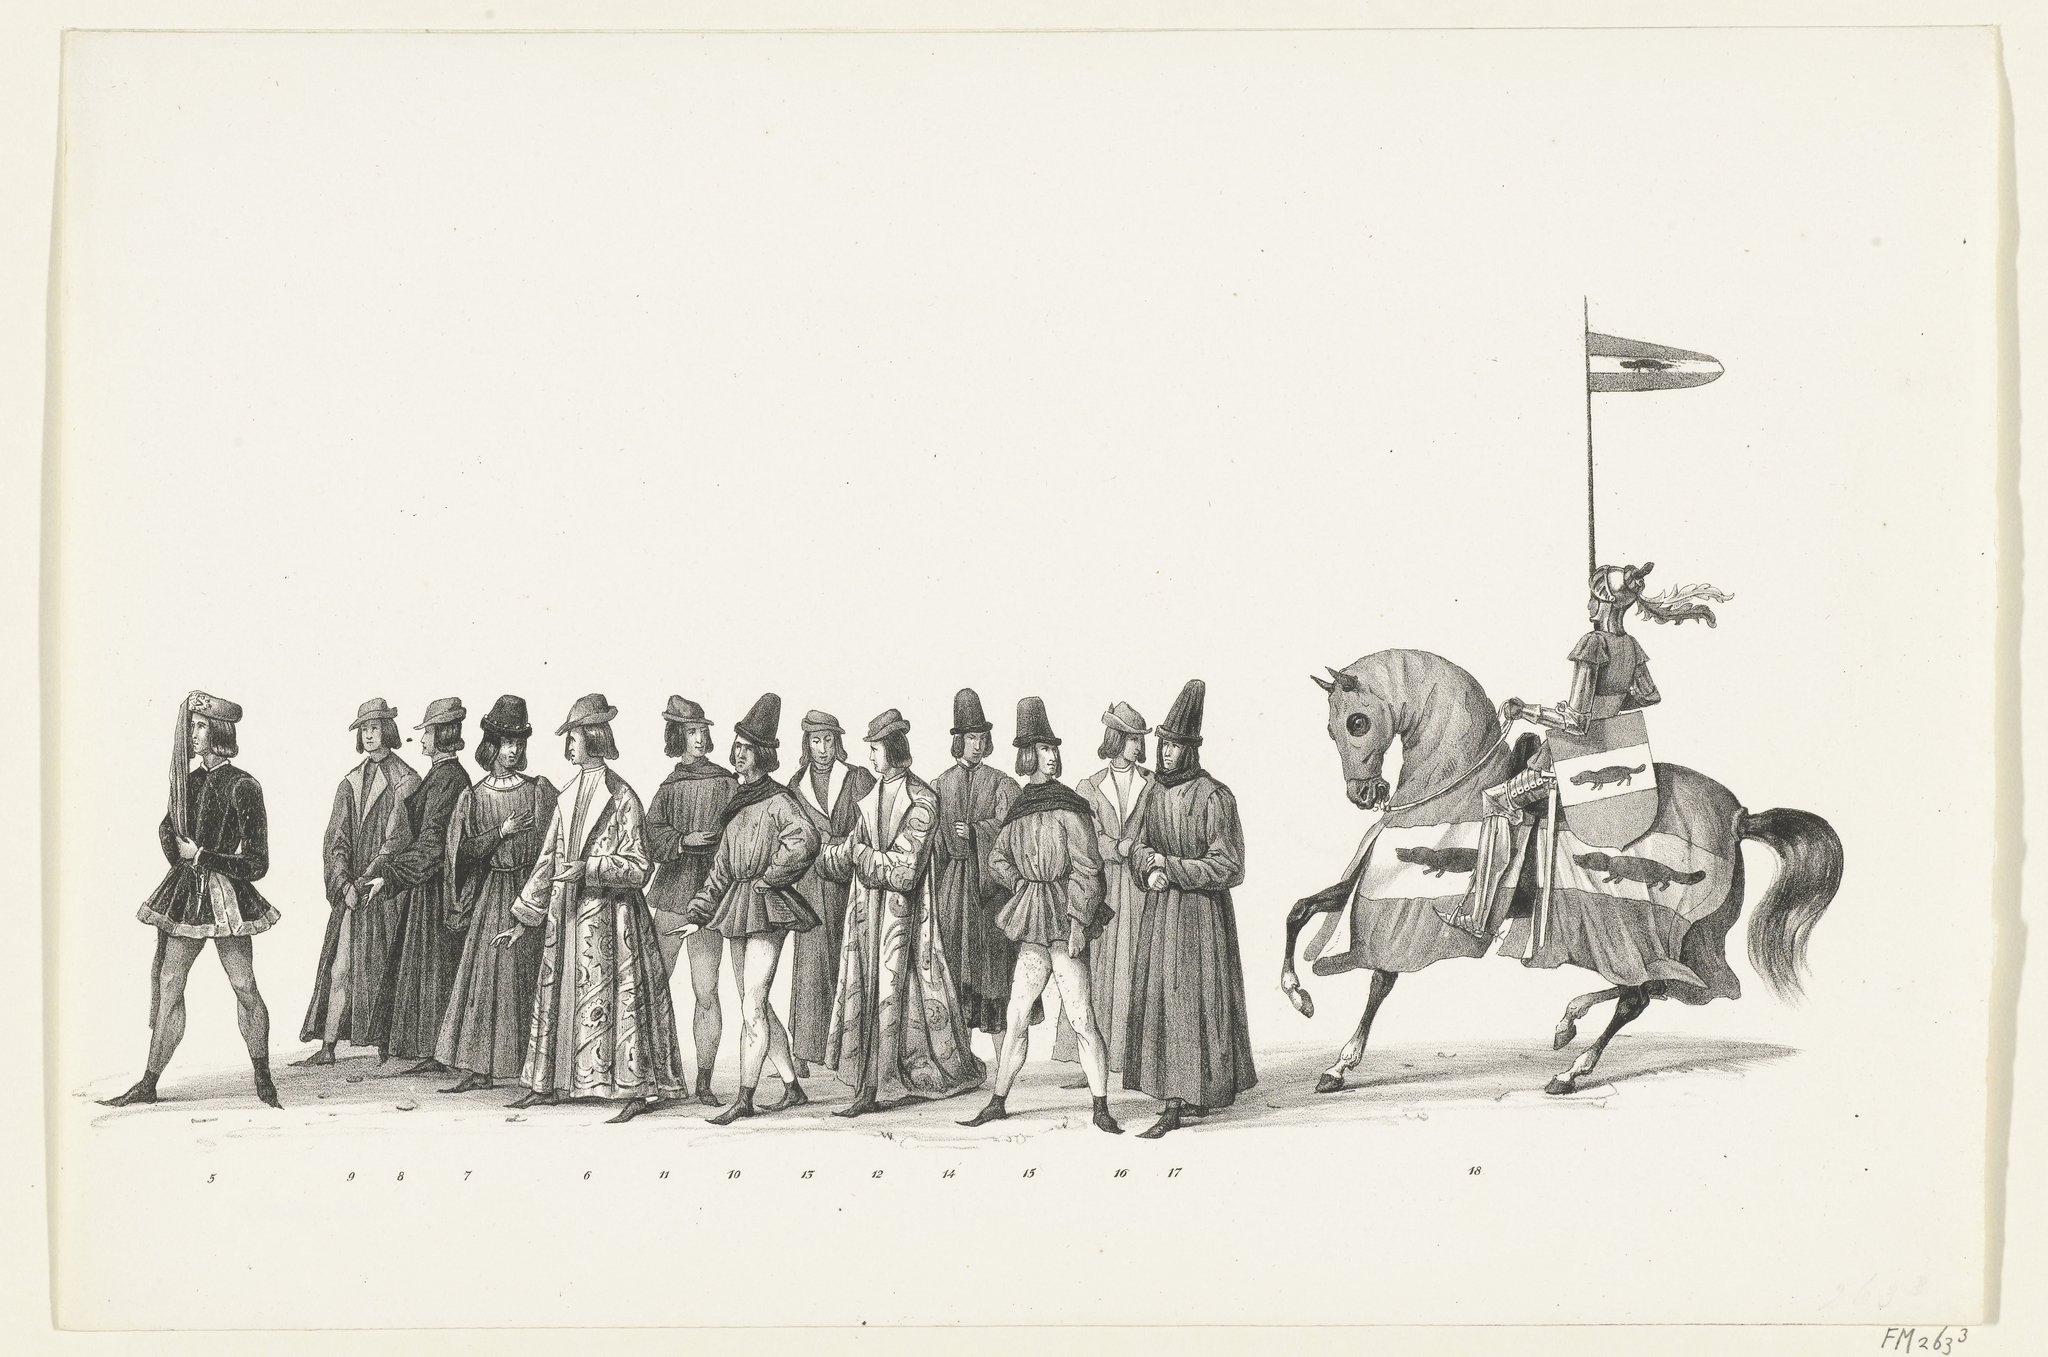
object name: print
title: Maskerade van de intocht van hertog Jan van Beieren te Leiden op 18 augustus 1420 door de Leidse studenten op 8 februari 1840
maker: Anonymous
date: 1840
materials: paper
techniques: lithograph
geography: netherlands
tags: jan van beieren, students' pageant, triumphal entry and public reception, pageant, 'entrée solennelle', 'joyeuse entrée', leiden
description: Optocht nrs 5-18: raadslieden en schepenen van Leiden. Onderdeel van de prentserie van de Maskerade van de intocht van hertog Jan van Beieren te Leiden op 18 augustus 1420 door de Leidse studenten op 8 februari 1840.